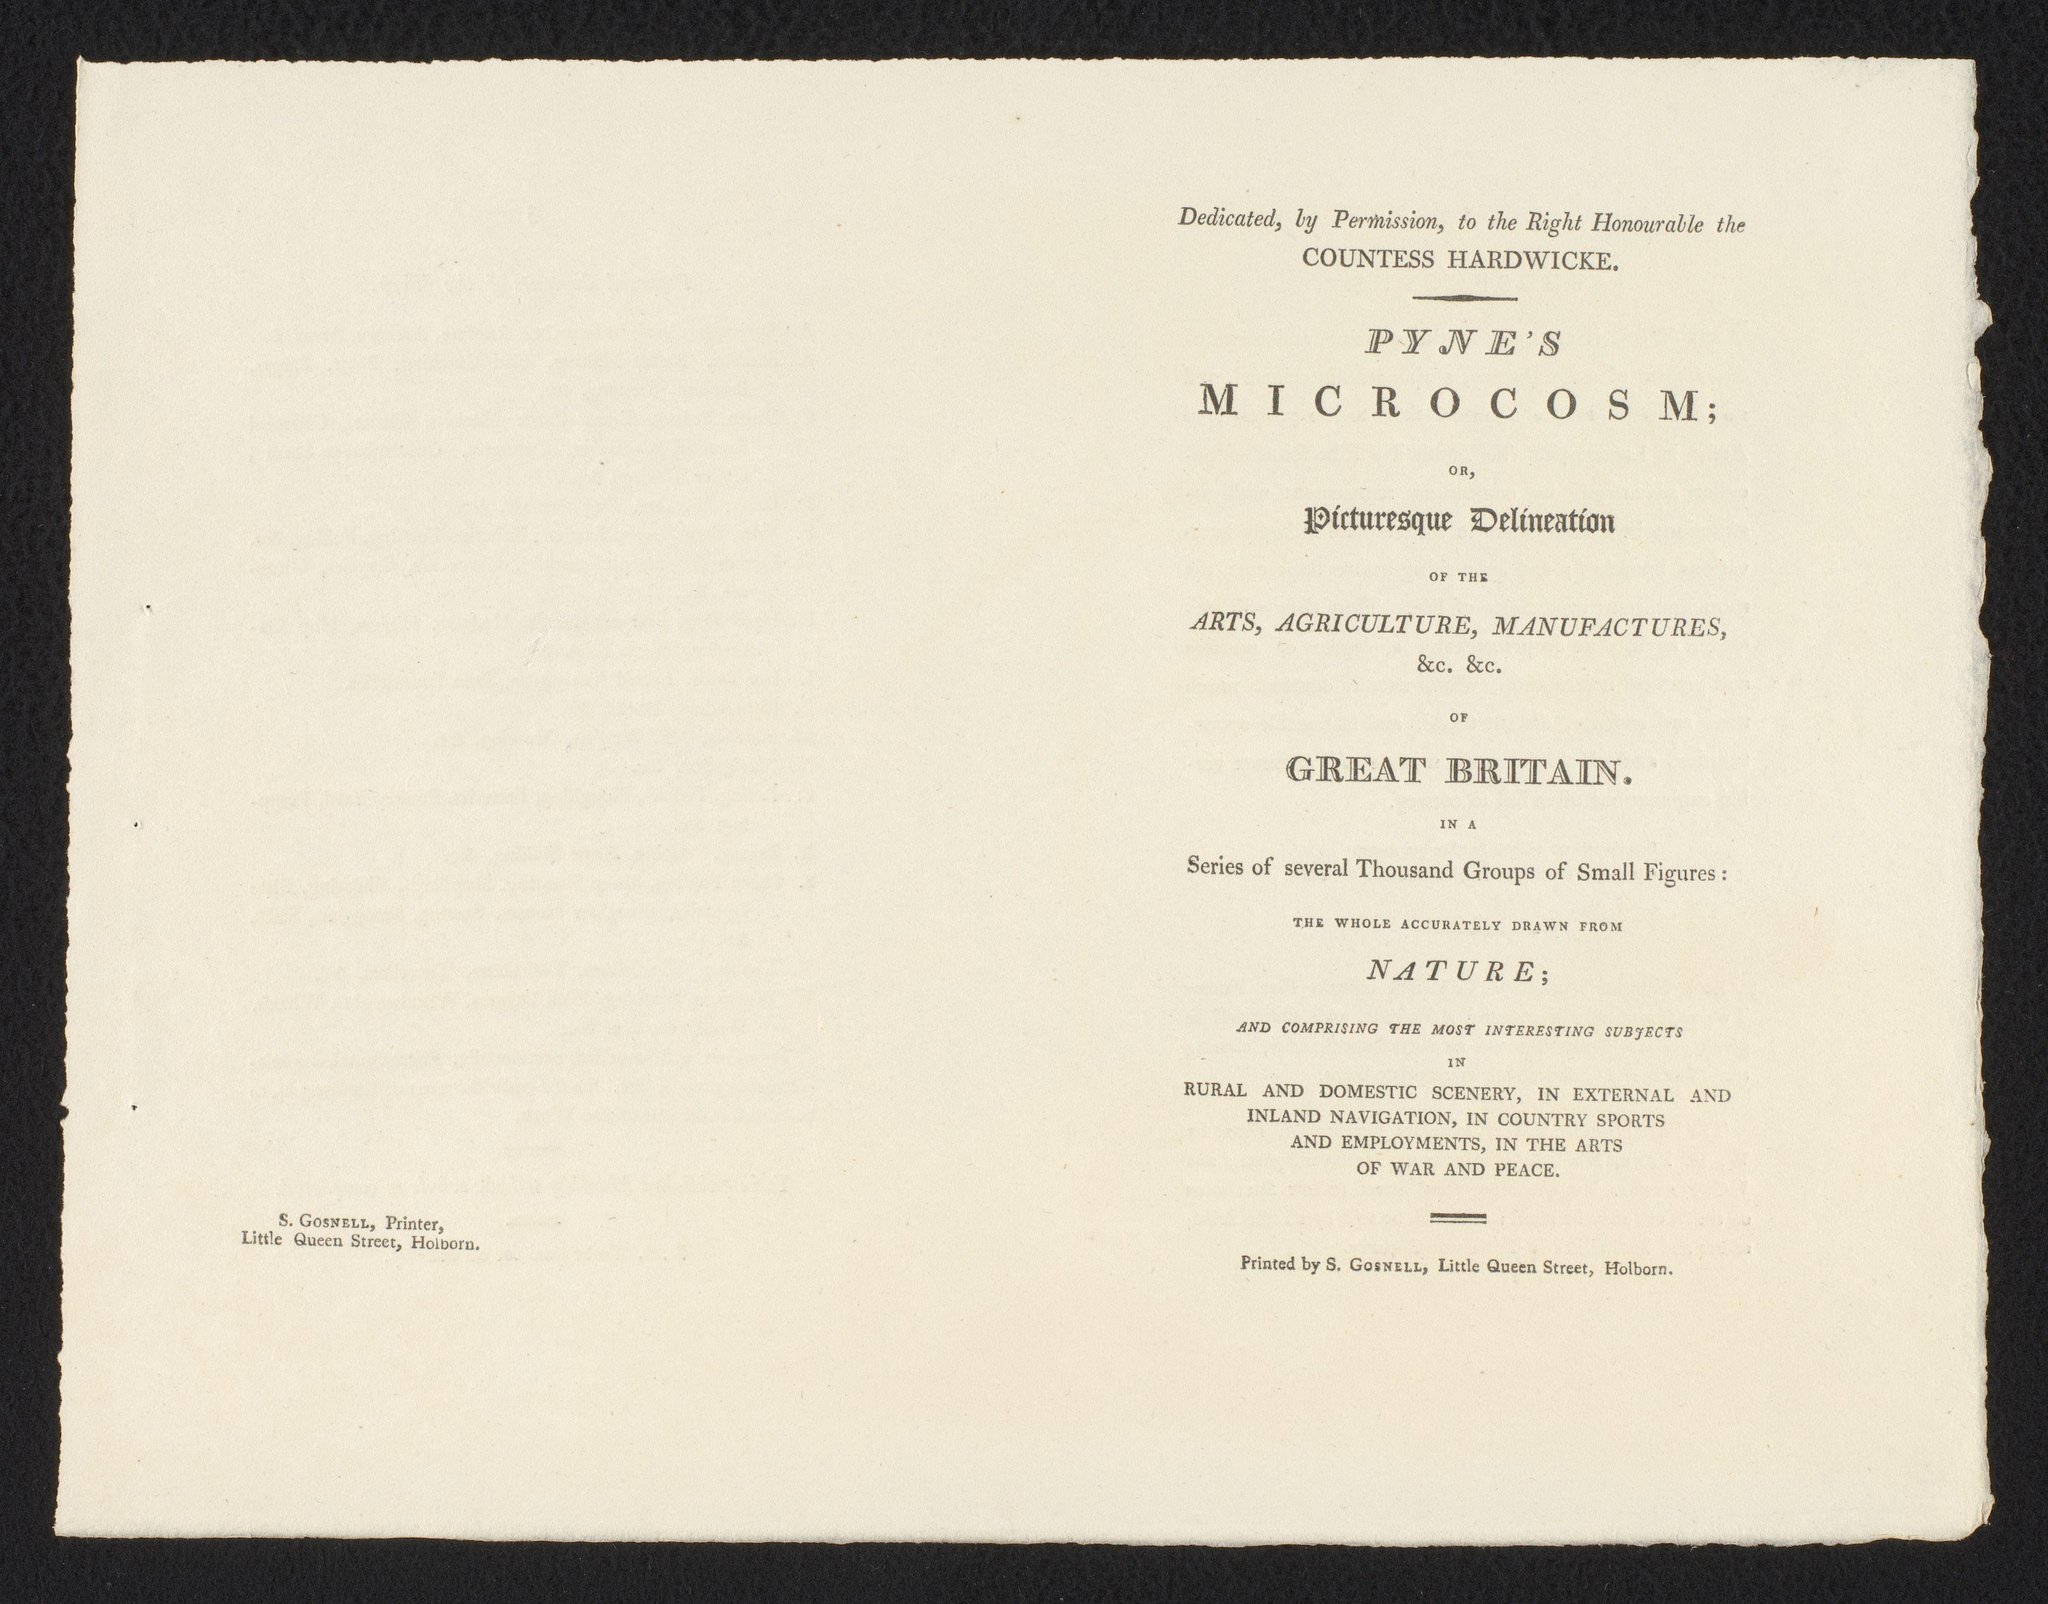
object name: prospectus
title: Pyne's Microcosm; or, Picturesque Delineation of the Arts, Agriculture, Manufactures, &c. &c. of Great Britain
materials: paper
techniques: letterpress printing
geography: london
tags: printed matter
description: Prospectus voor een serie in drie delen; elk deel bestond uit twaalf afleveringen, elk voorzien van vijf platen.